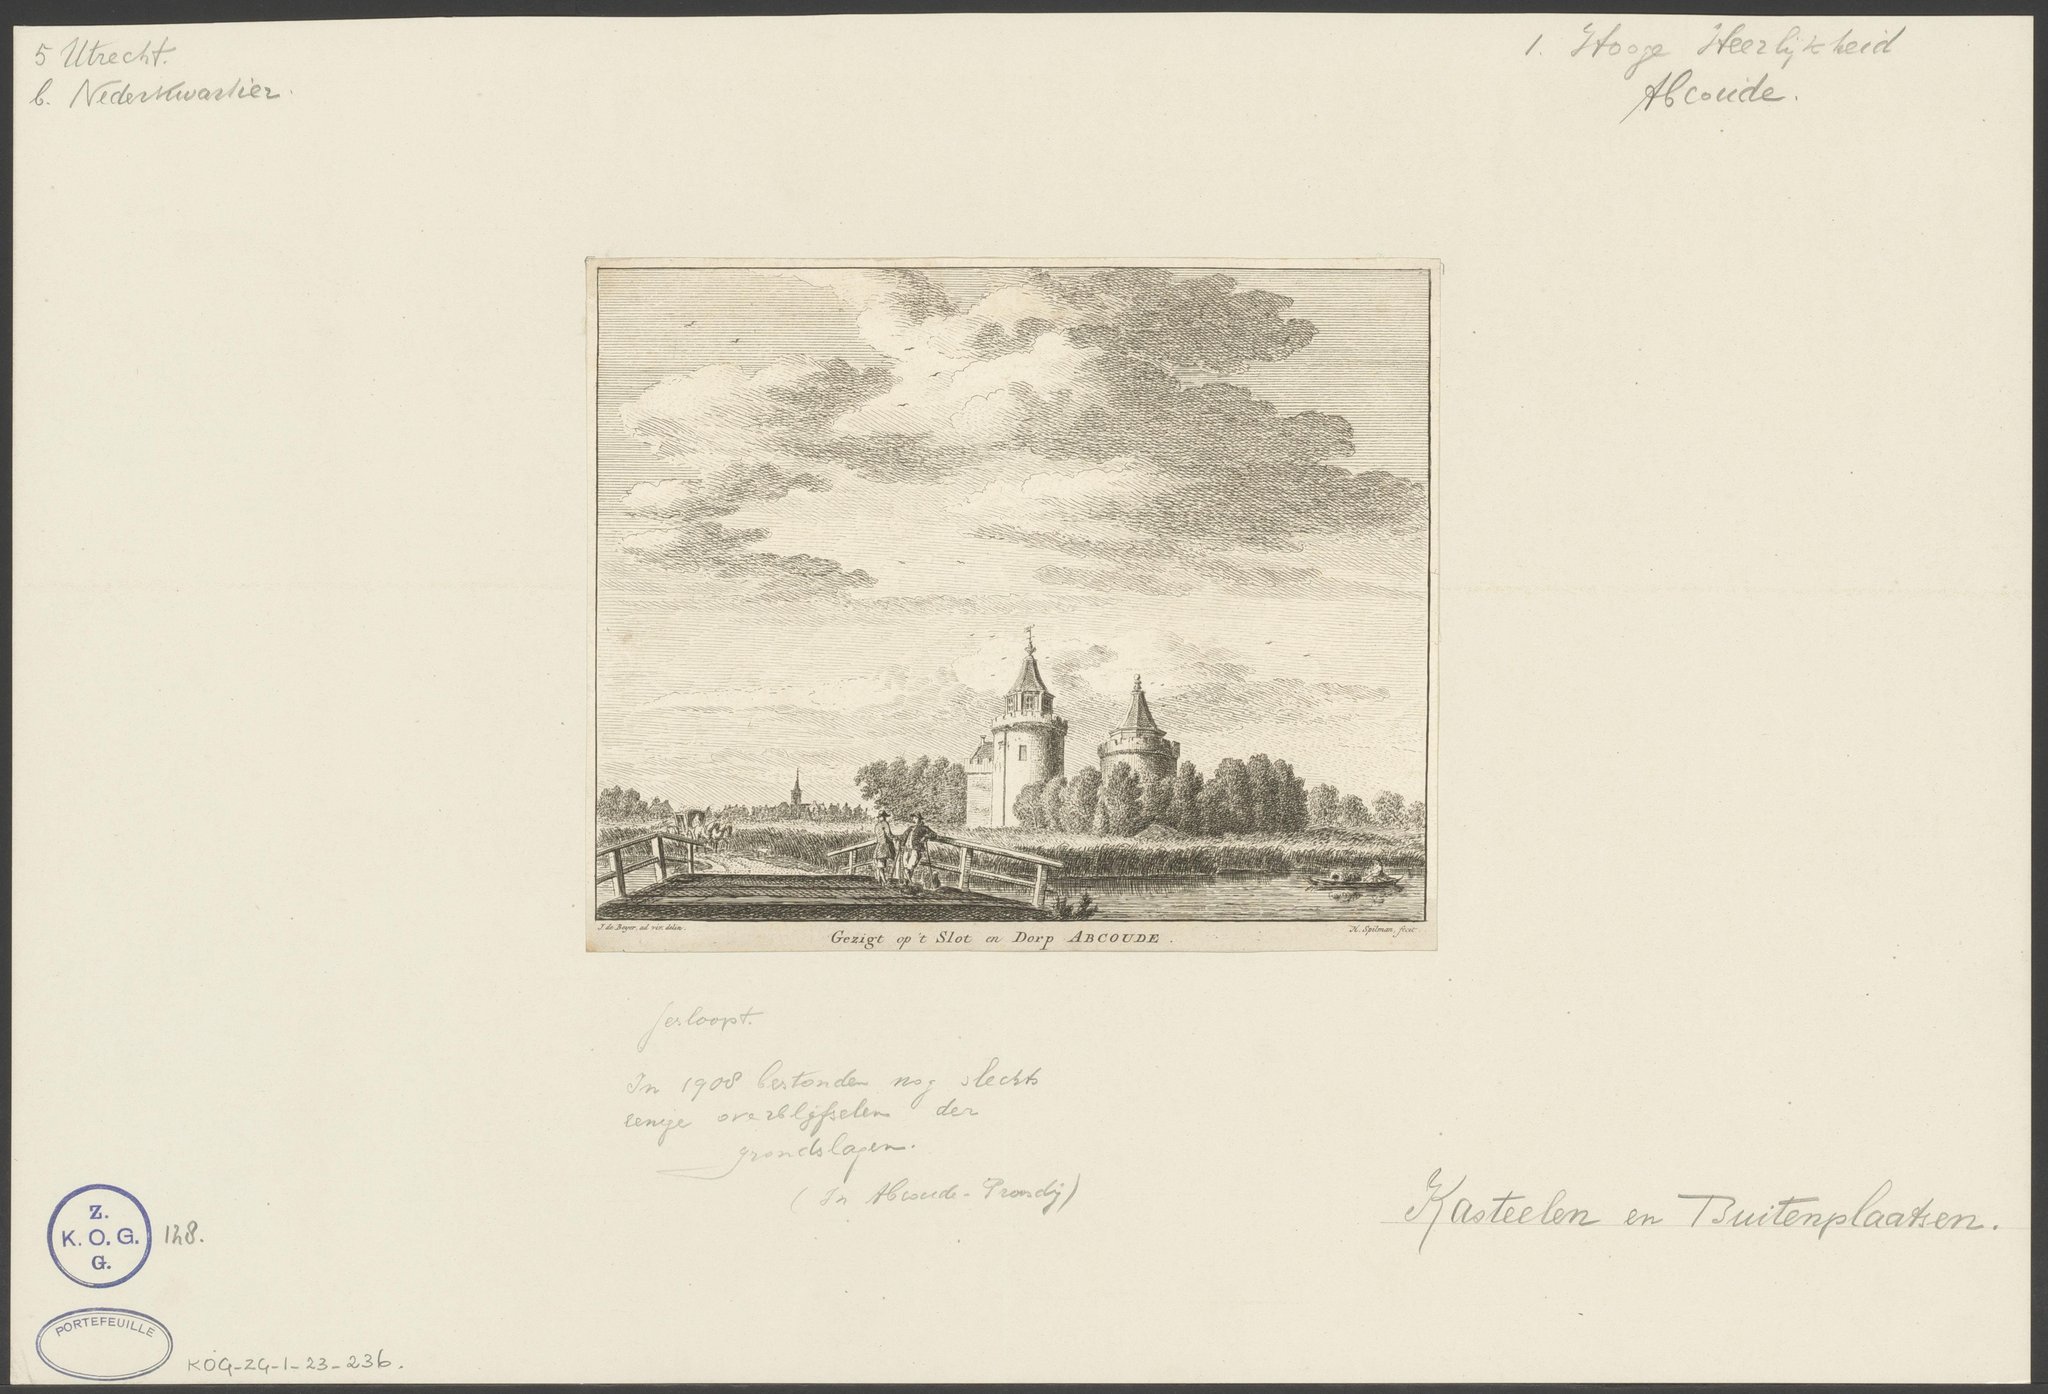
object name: print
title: Gezicht op kasteel Abcoude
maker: hendrik spilman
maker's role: draughtsman, painter, print maker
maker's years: 1721-1784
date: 1772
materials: paper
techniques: etching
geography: abcoude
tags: castle, landscape with bridge, viaduct or aqueduct, landscape with tower or castle, bridge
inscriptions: stamp, collector's mark: Lugt 1641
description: Prent mogelijk uit: Hedendaegsche historie, of tegenwoordige staet van alle volkeren; in opzigte hunner landsgelegenheit, personen, klederen, gebouwen, zeden, wetten, gewoontens, godsdienst, regering. Amsterdam: Isaak Tirion, 1772.